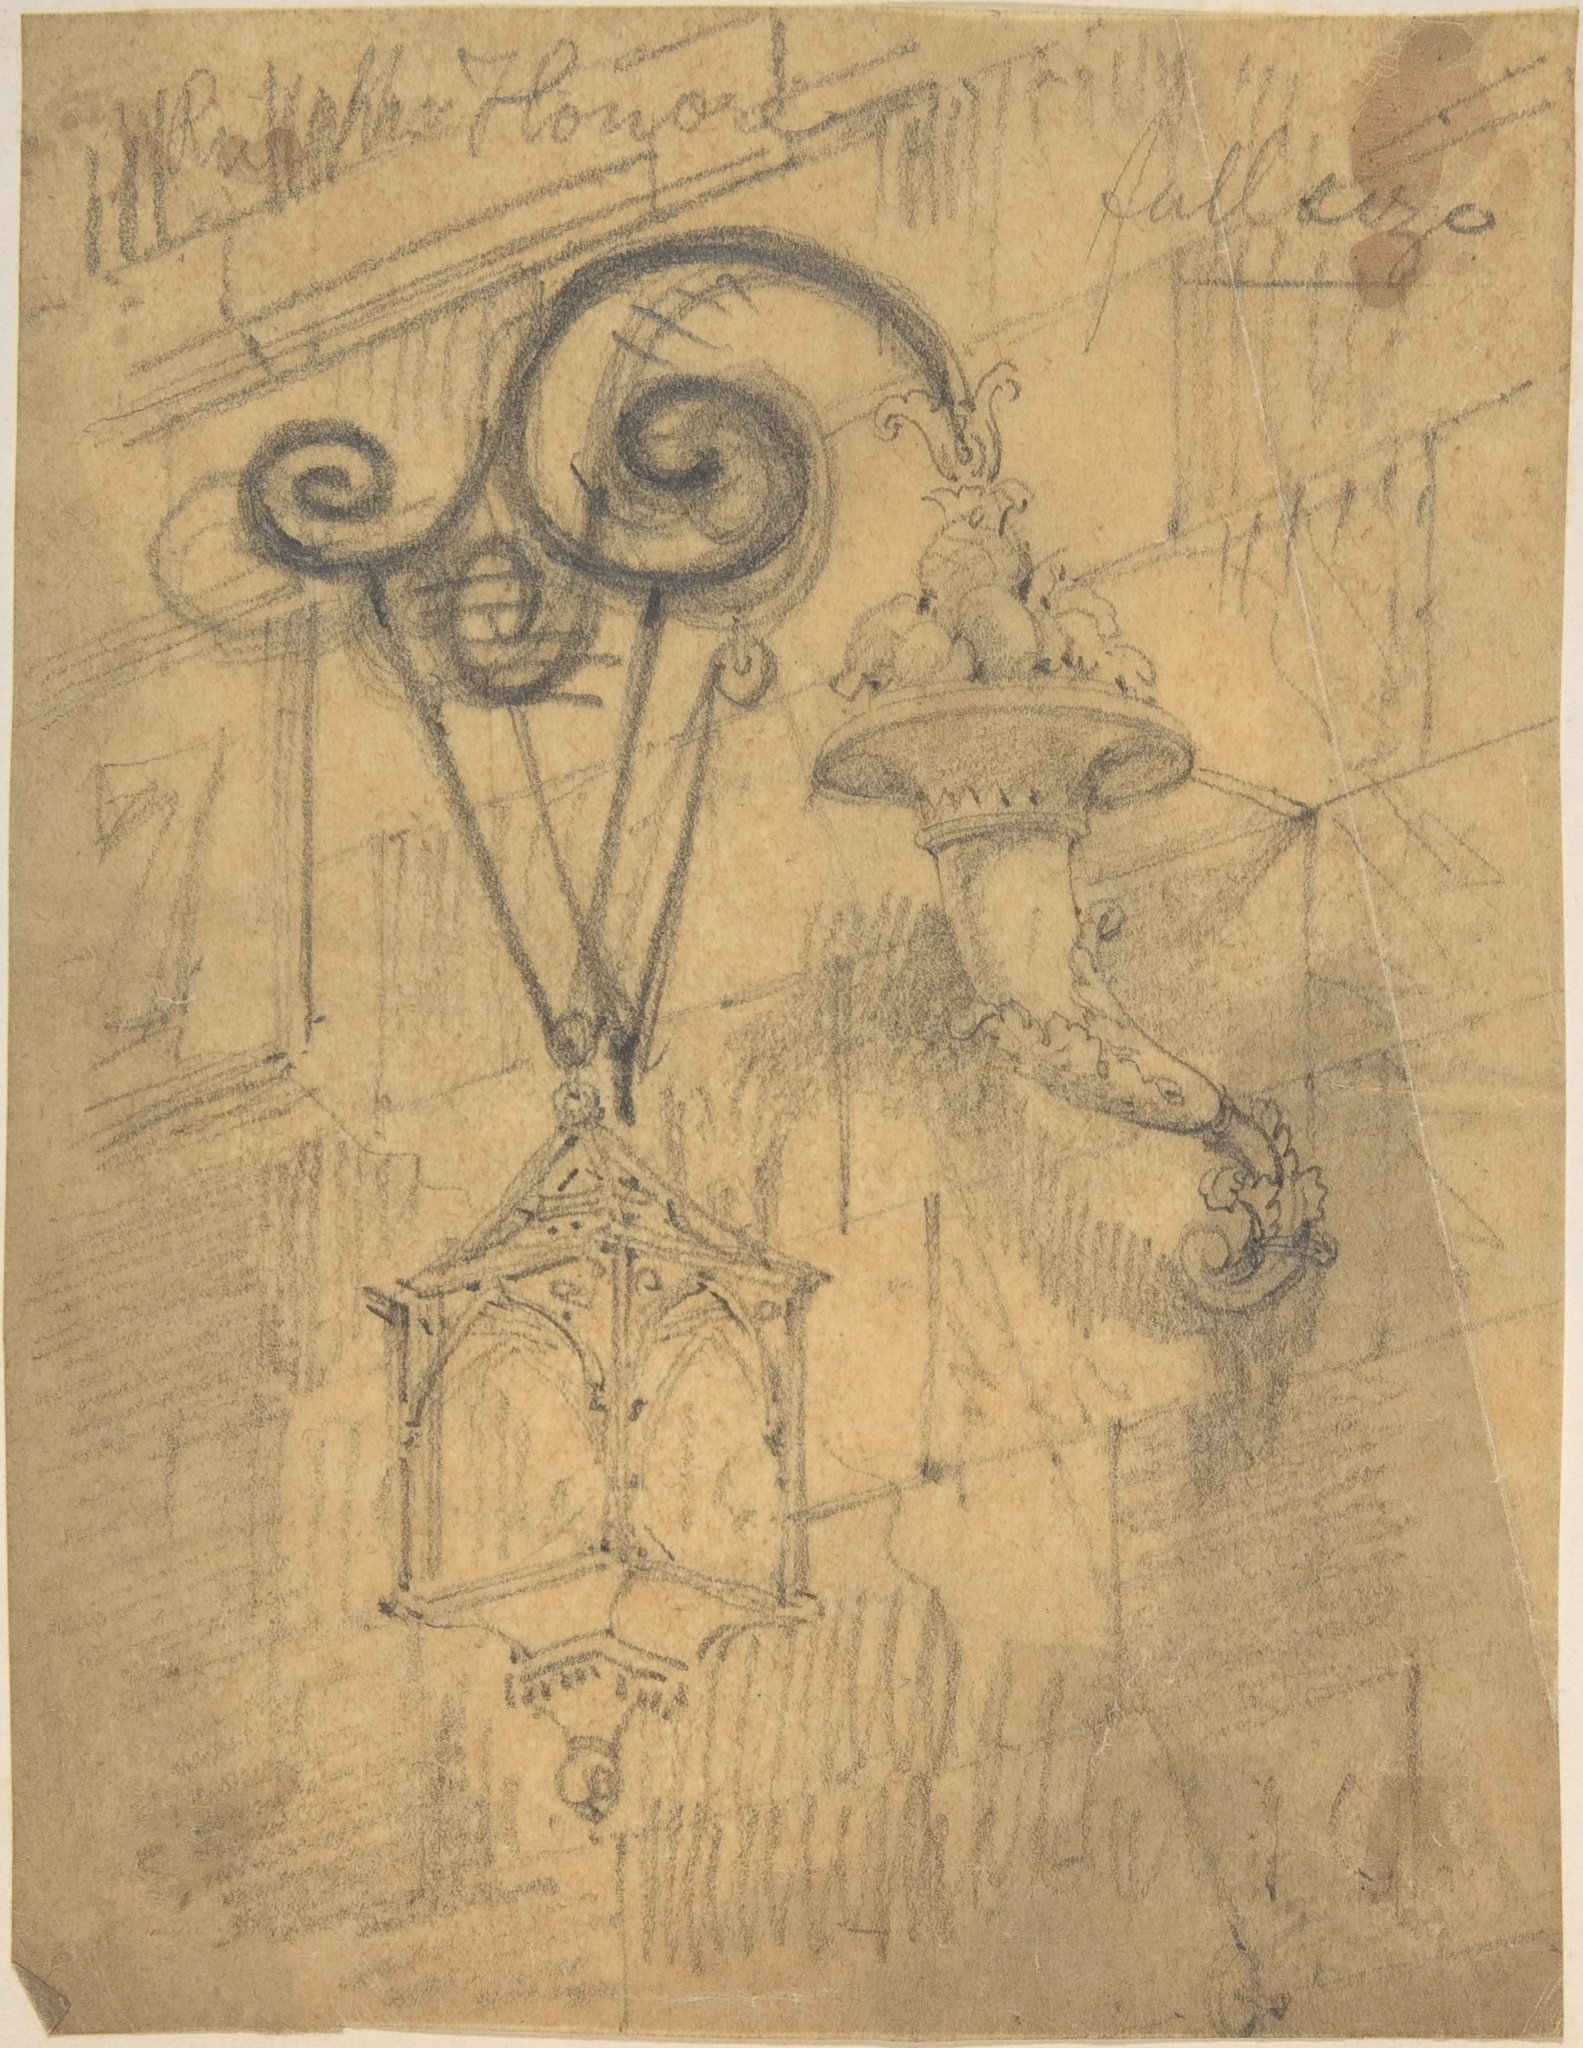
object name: drawing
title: Metal Bracket Supporting a Street lamp, St. Honoré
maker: anonymous, british, 19th century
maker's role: artist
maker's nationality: british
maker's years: 1800-1900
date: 1851-1900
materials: graphite